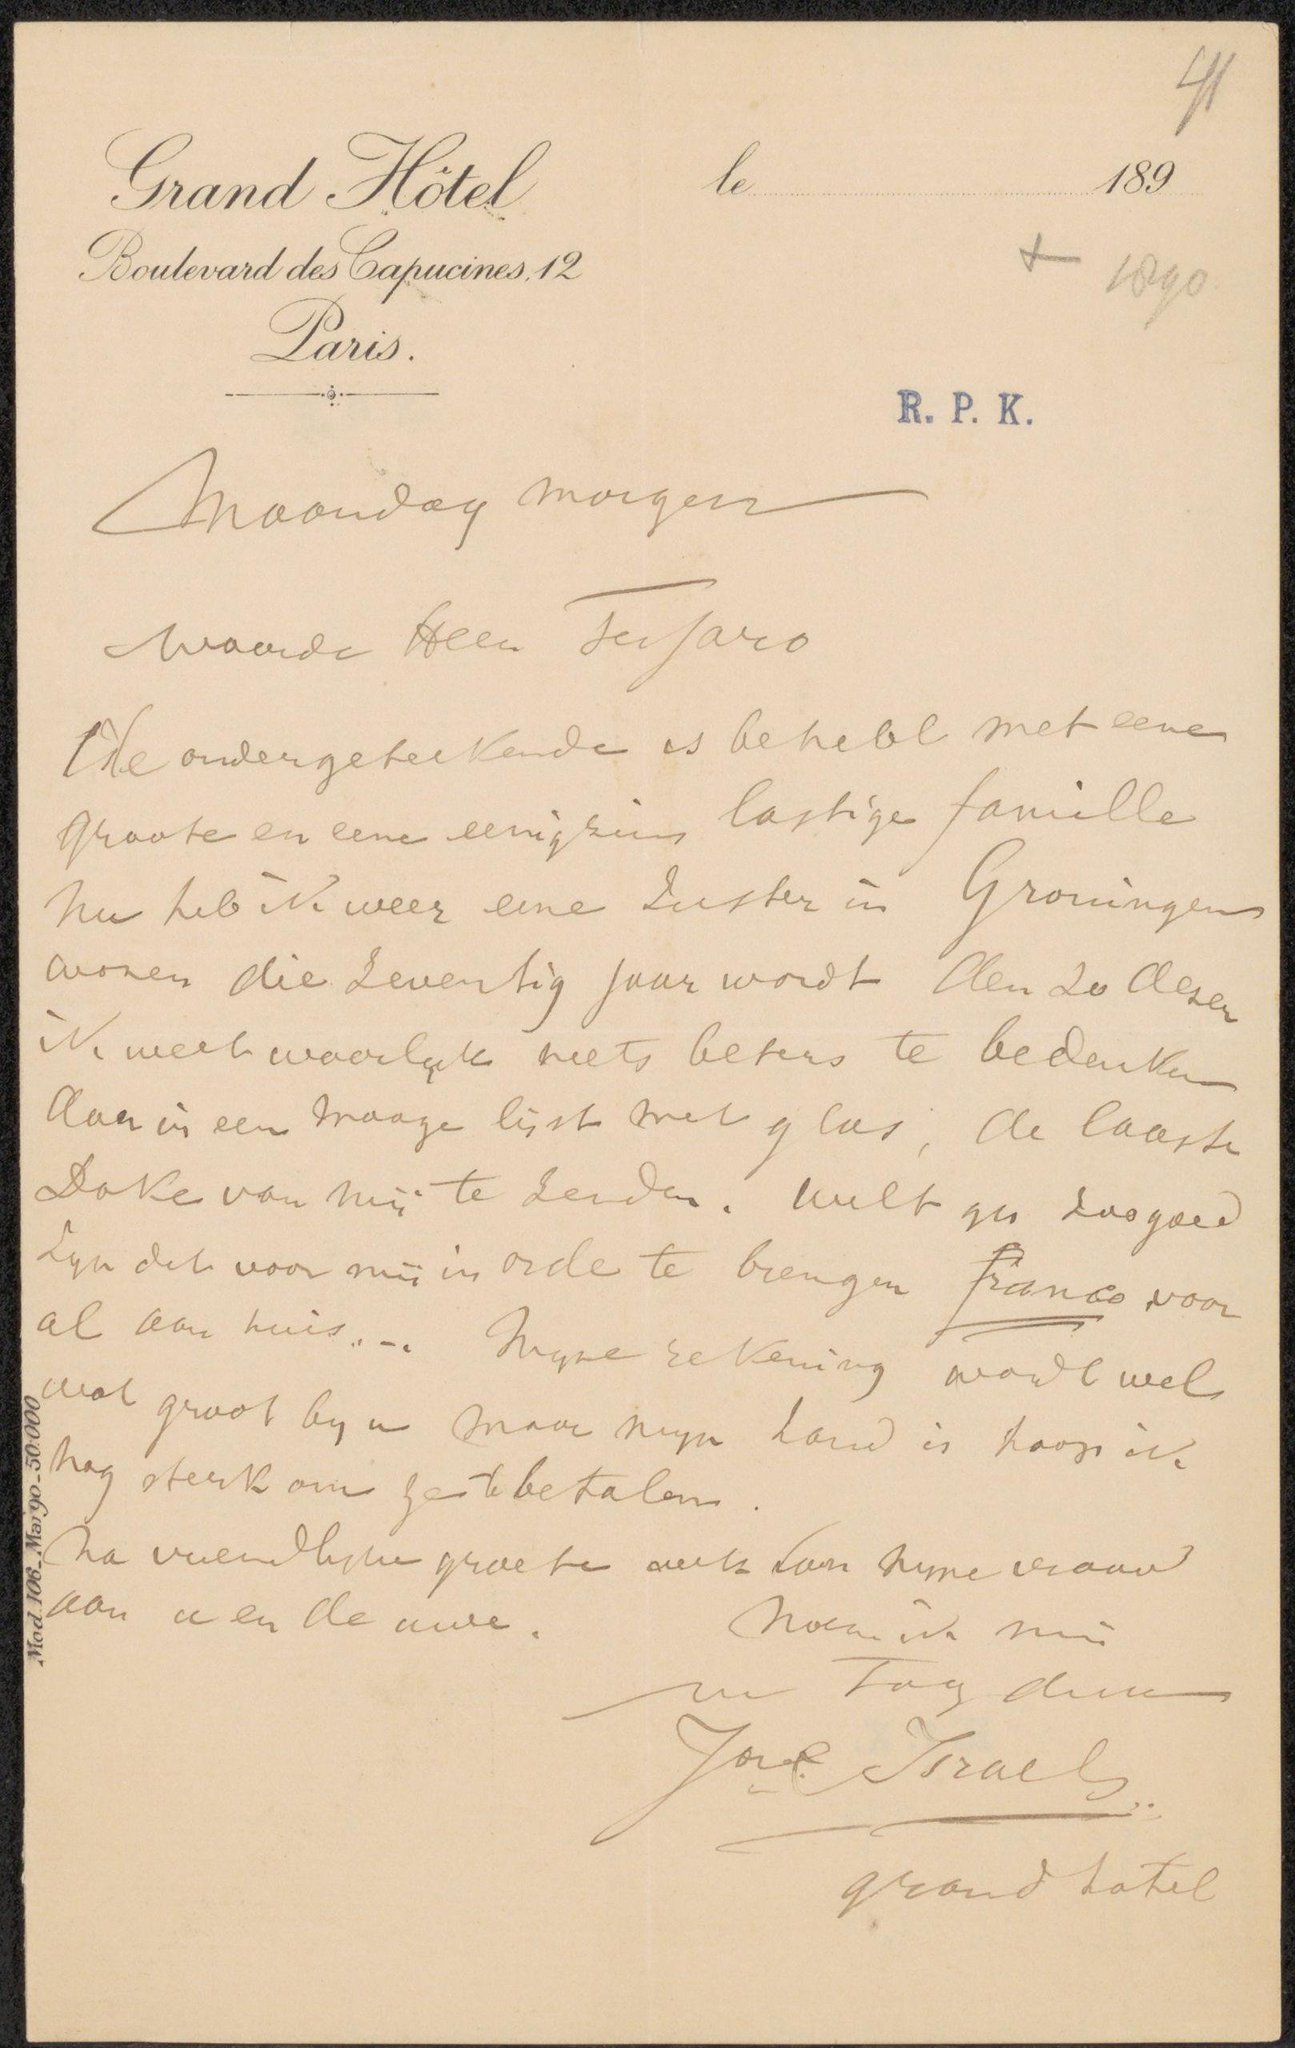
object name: letter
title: Brief aan Filippo Tessaro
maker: jozef israëls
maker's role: draughtsman, painter, print maker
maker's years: 1824-1911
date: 1890-1907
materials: ink, paper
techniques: pen, printing, writing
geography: paris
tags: amsterdam, painter, print maker, draughtsman, carel lodewijk dake, family life, money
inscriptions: collector's mark: Lugt 2233, watermark